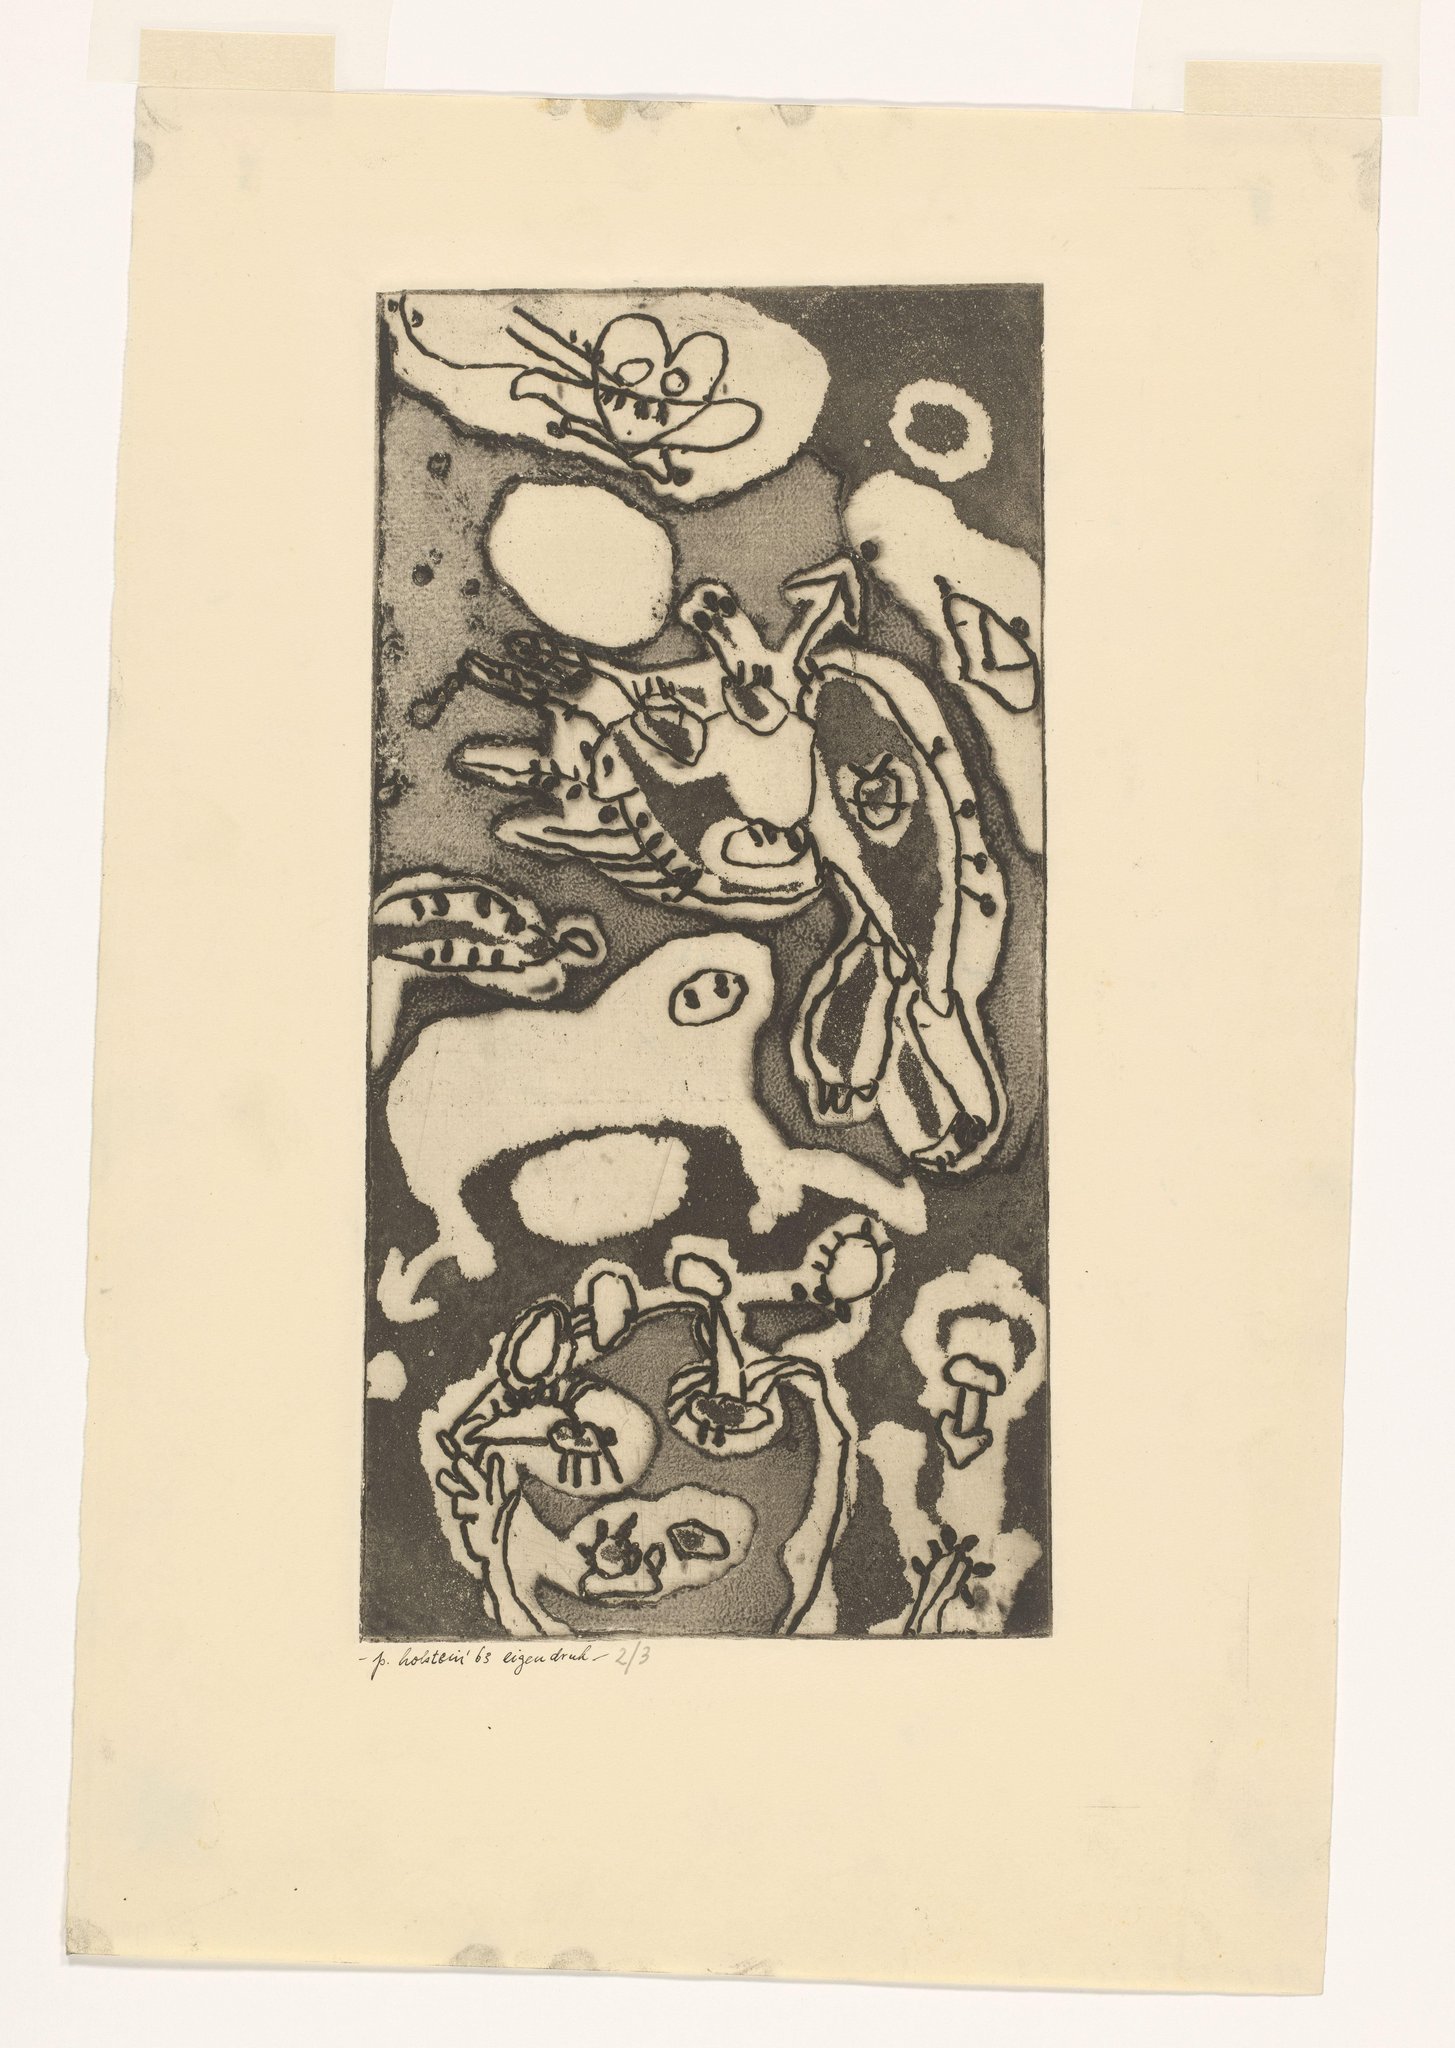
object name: print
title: Hart met ogen en andere wezens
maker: pieter holstein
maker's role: draughtsman, painter, print maker, sculptor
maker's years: 1934-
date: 1963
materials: paper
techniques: aquatint, etching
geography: amsterdam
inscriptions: signature and date: ‘p. holstein '63’, edition: ‘eigen druk 2/3’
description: De huidige titels zijn door het museum toegekend bij gebrek aan informatie over een originele titel.